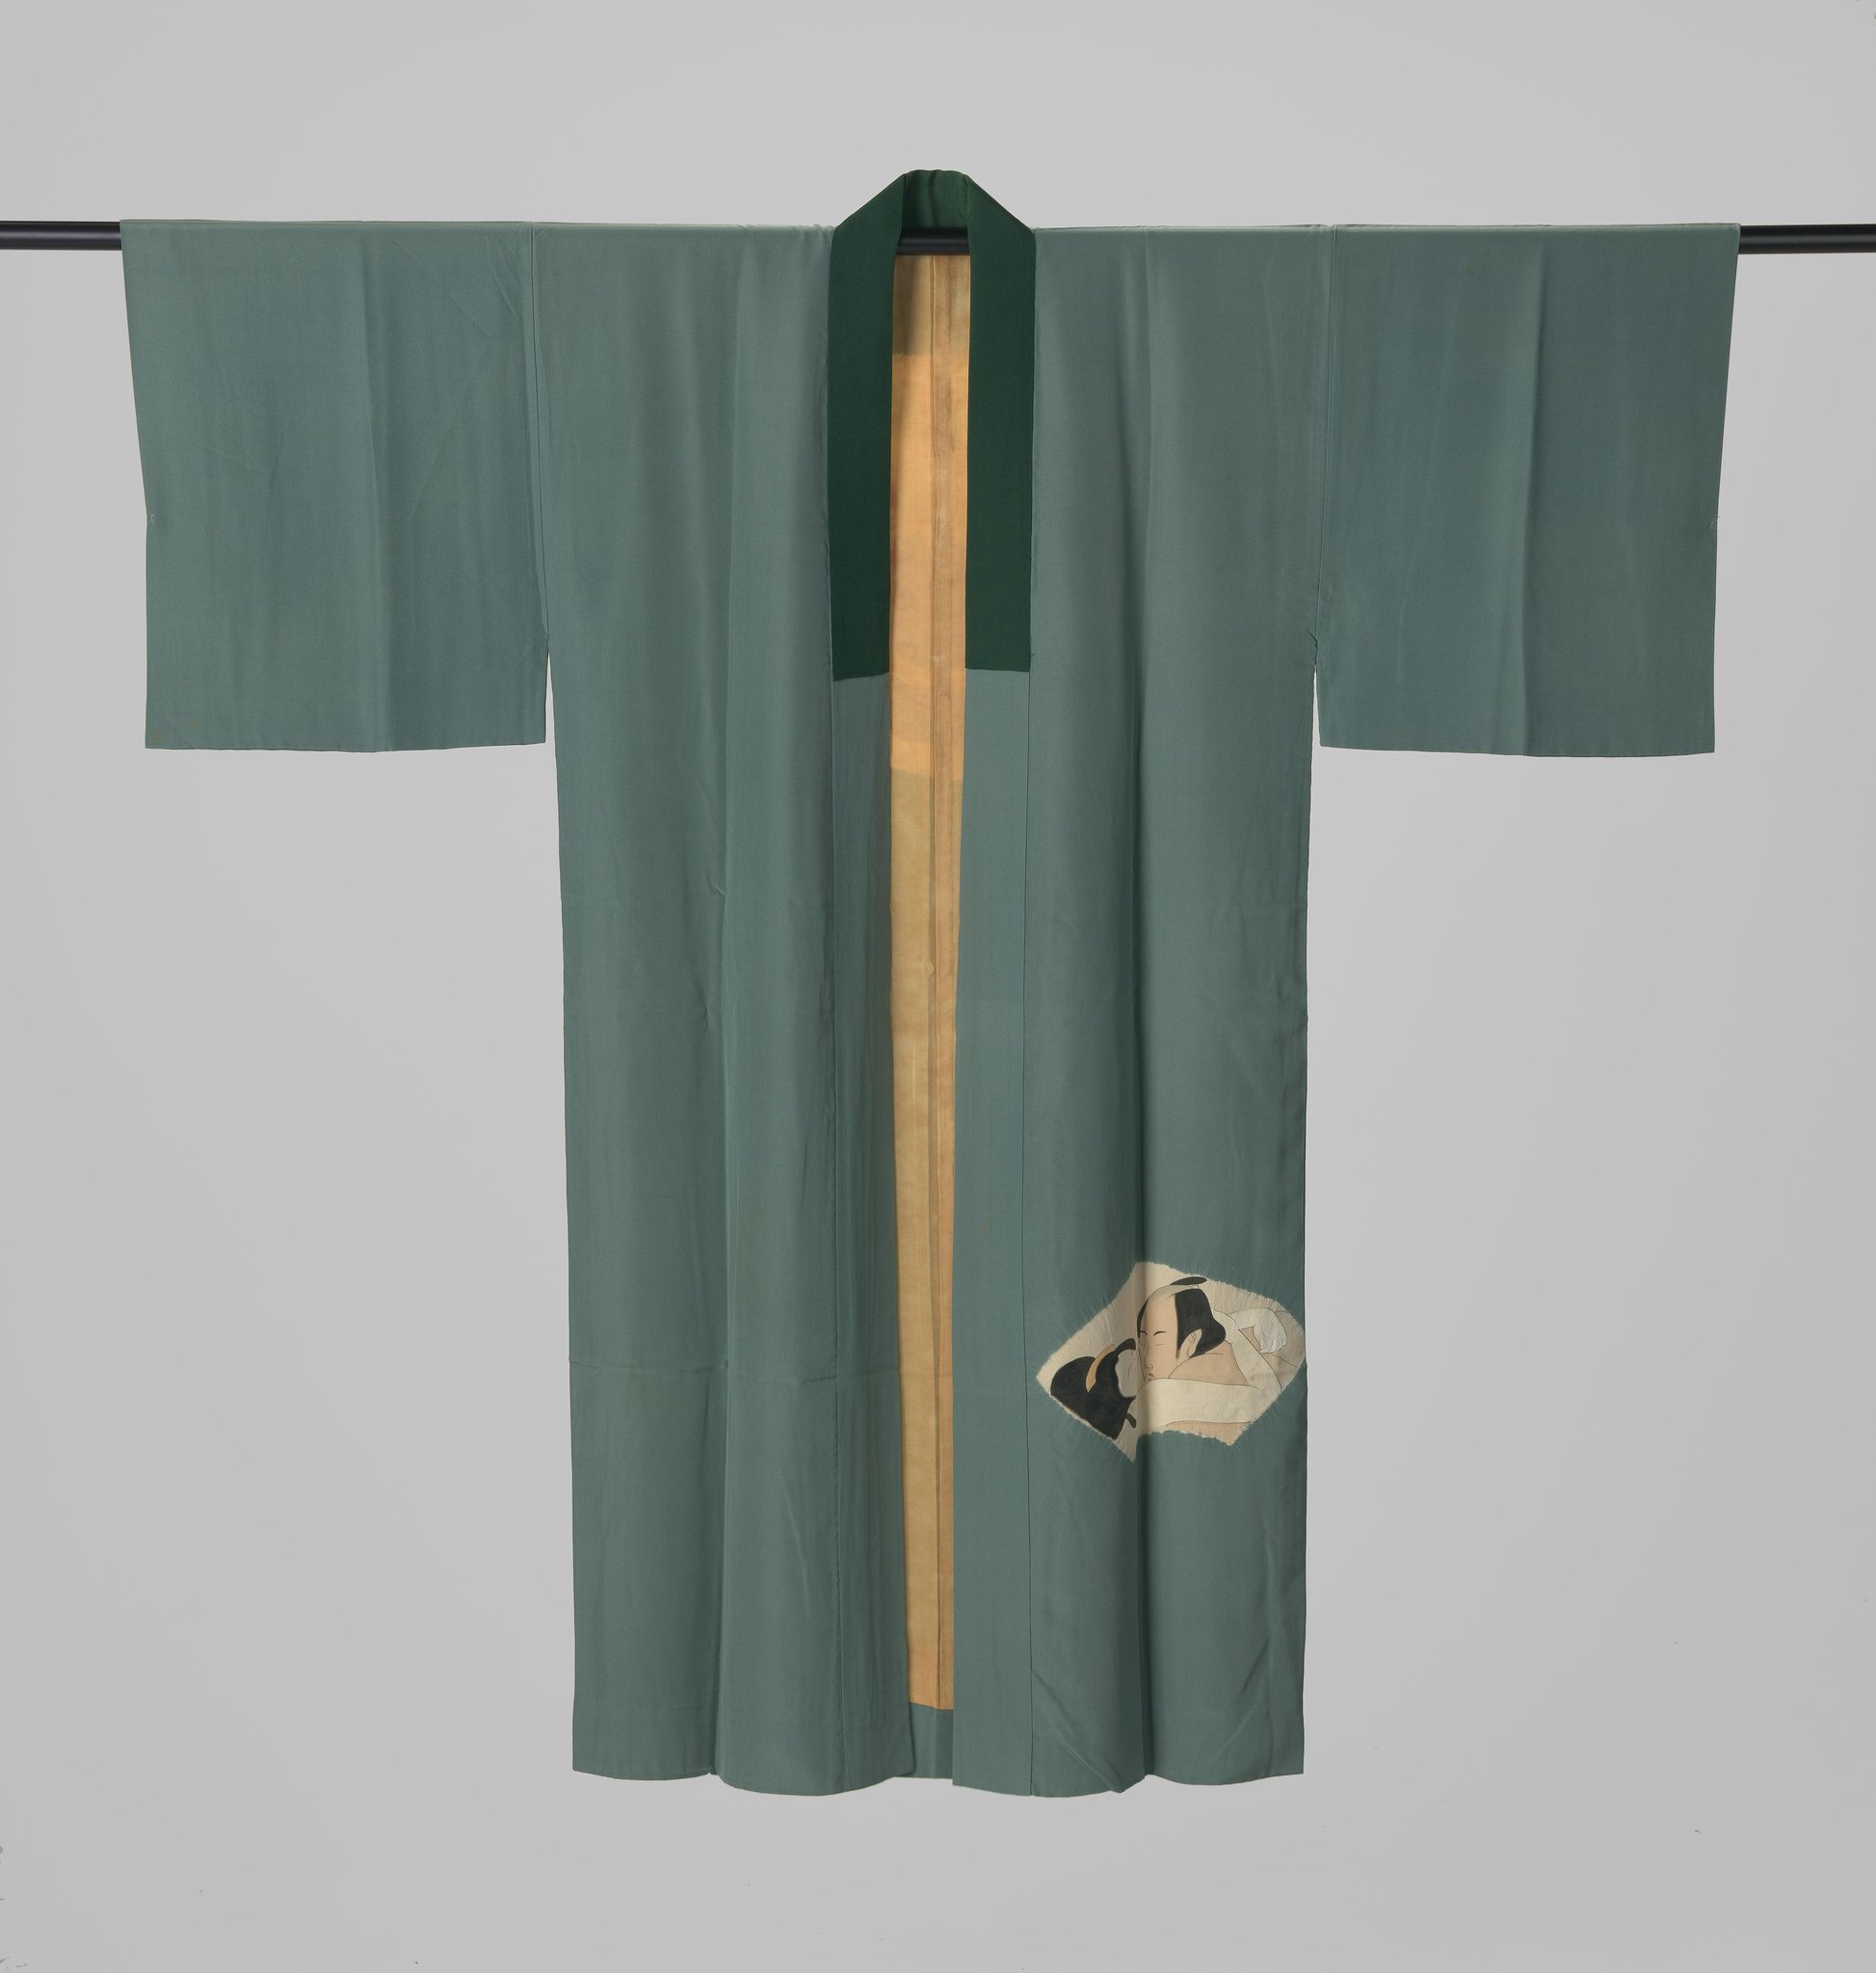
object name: kimono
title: Onderkimono voor mannen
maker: Anonymous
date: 1920-1940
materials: paint, silk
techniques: weave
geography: japan